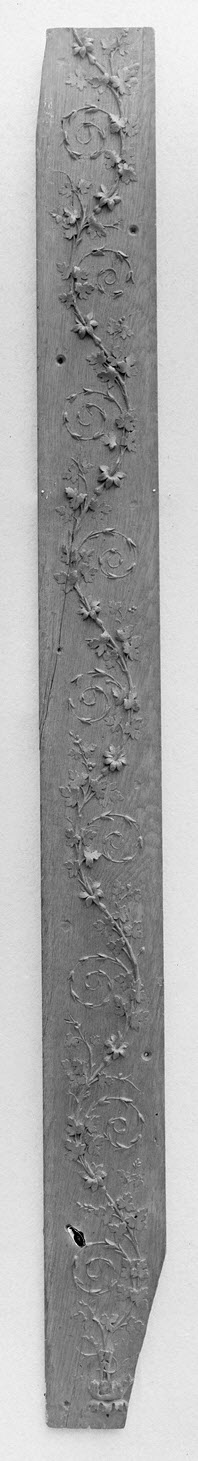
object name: pilaster panel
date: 1701-1800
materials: wood, wax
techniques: polish